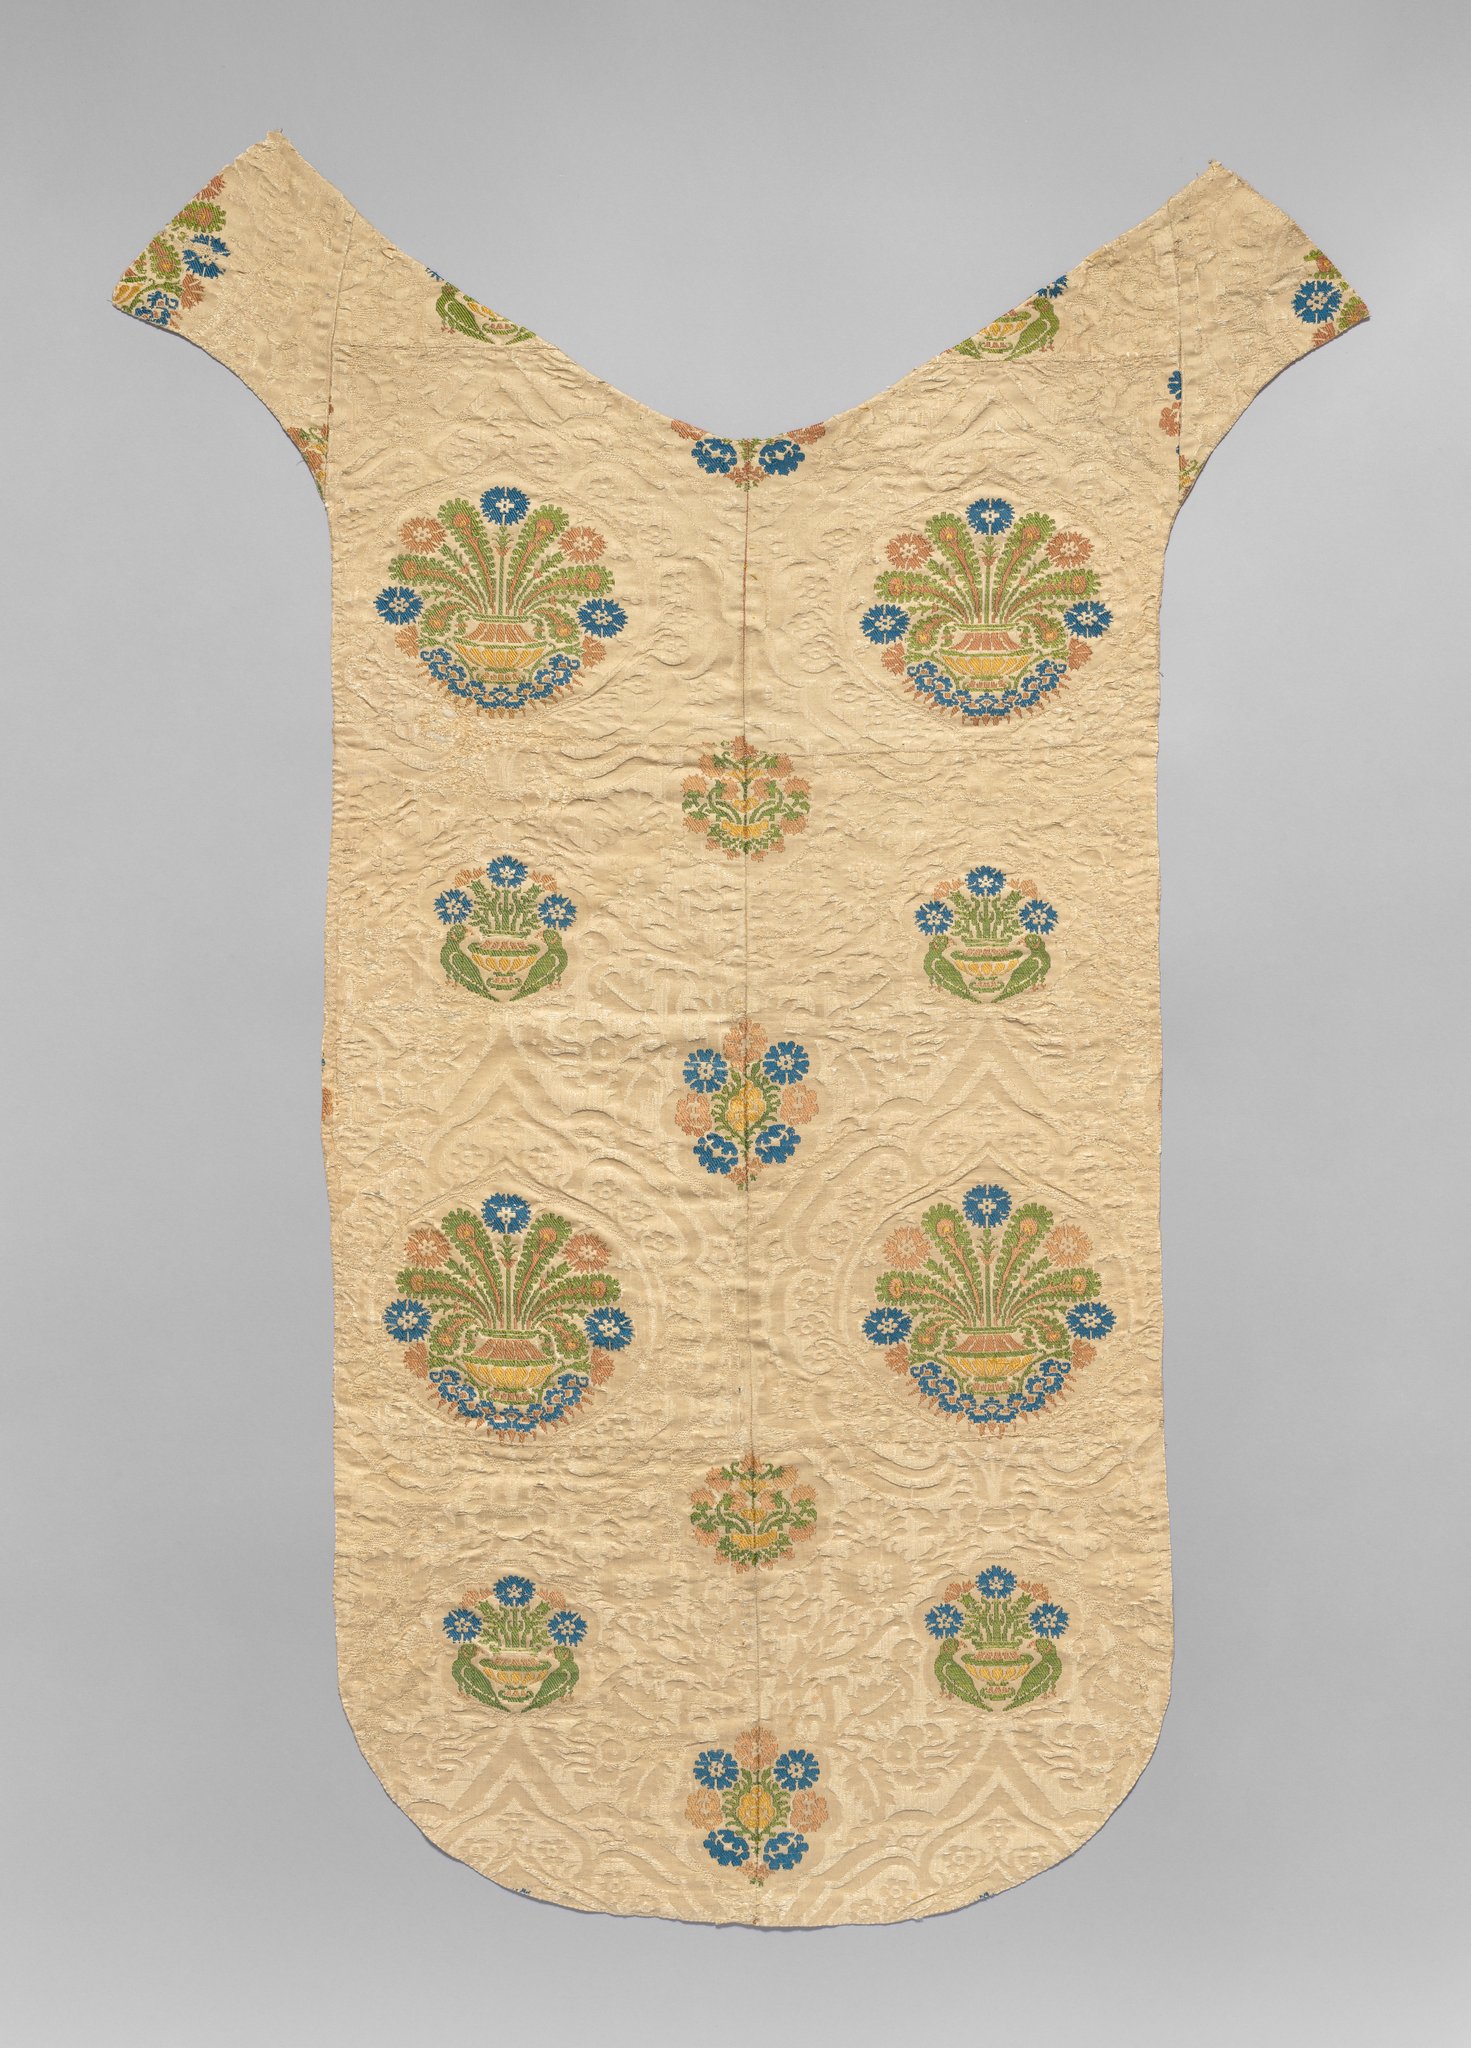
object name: chasuble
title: White and Polychrome Brocaded Damask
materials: silk